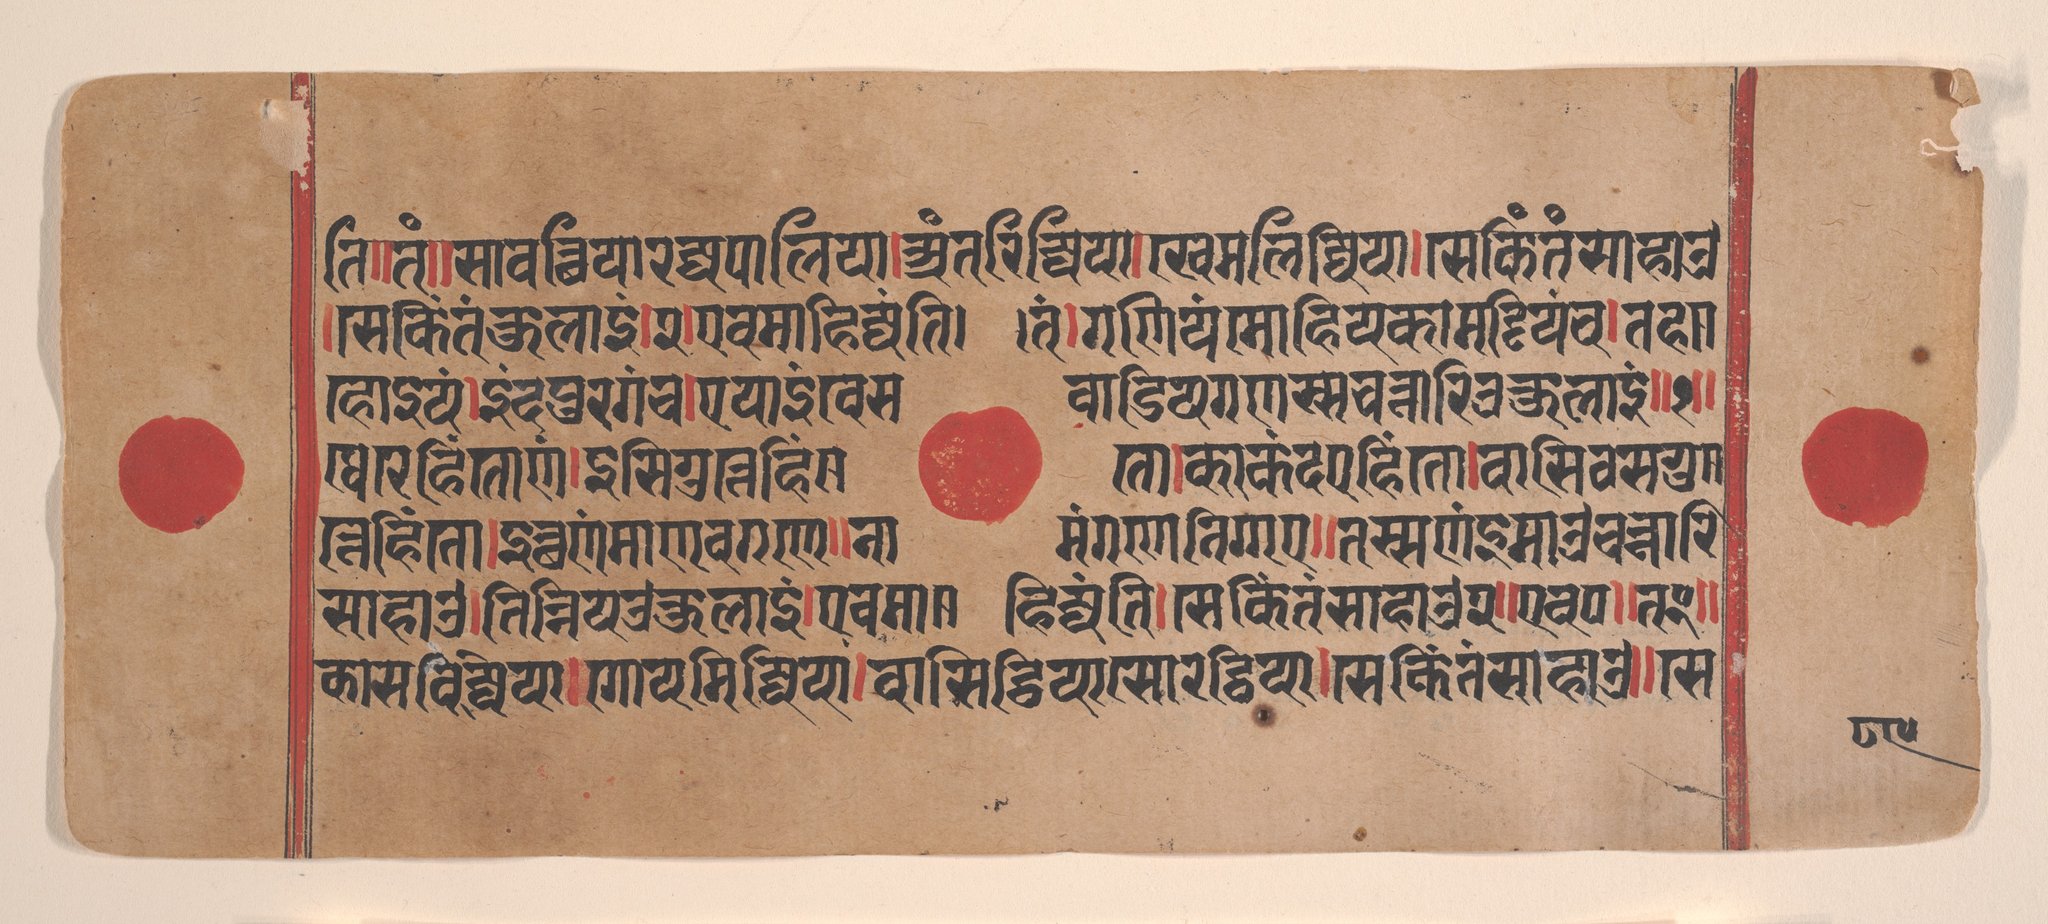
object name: folio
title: Page from a Dispersed Kalpa Sutra (Jain Book of Rituals)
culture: indian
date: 1401-1500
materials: gold, ink, paper, watercolor